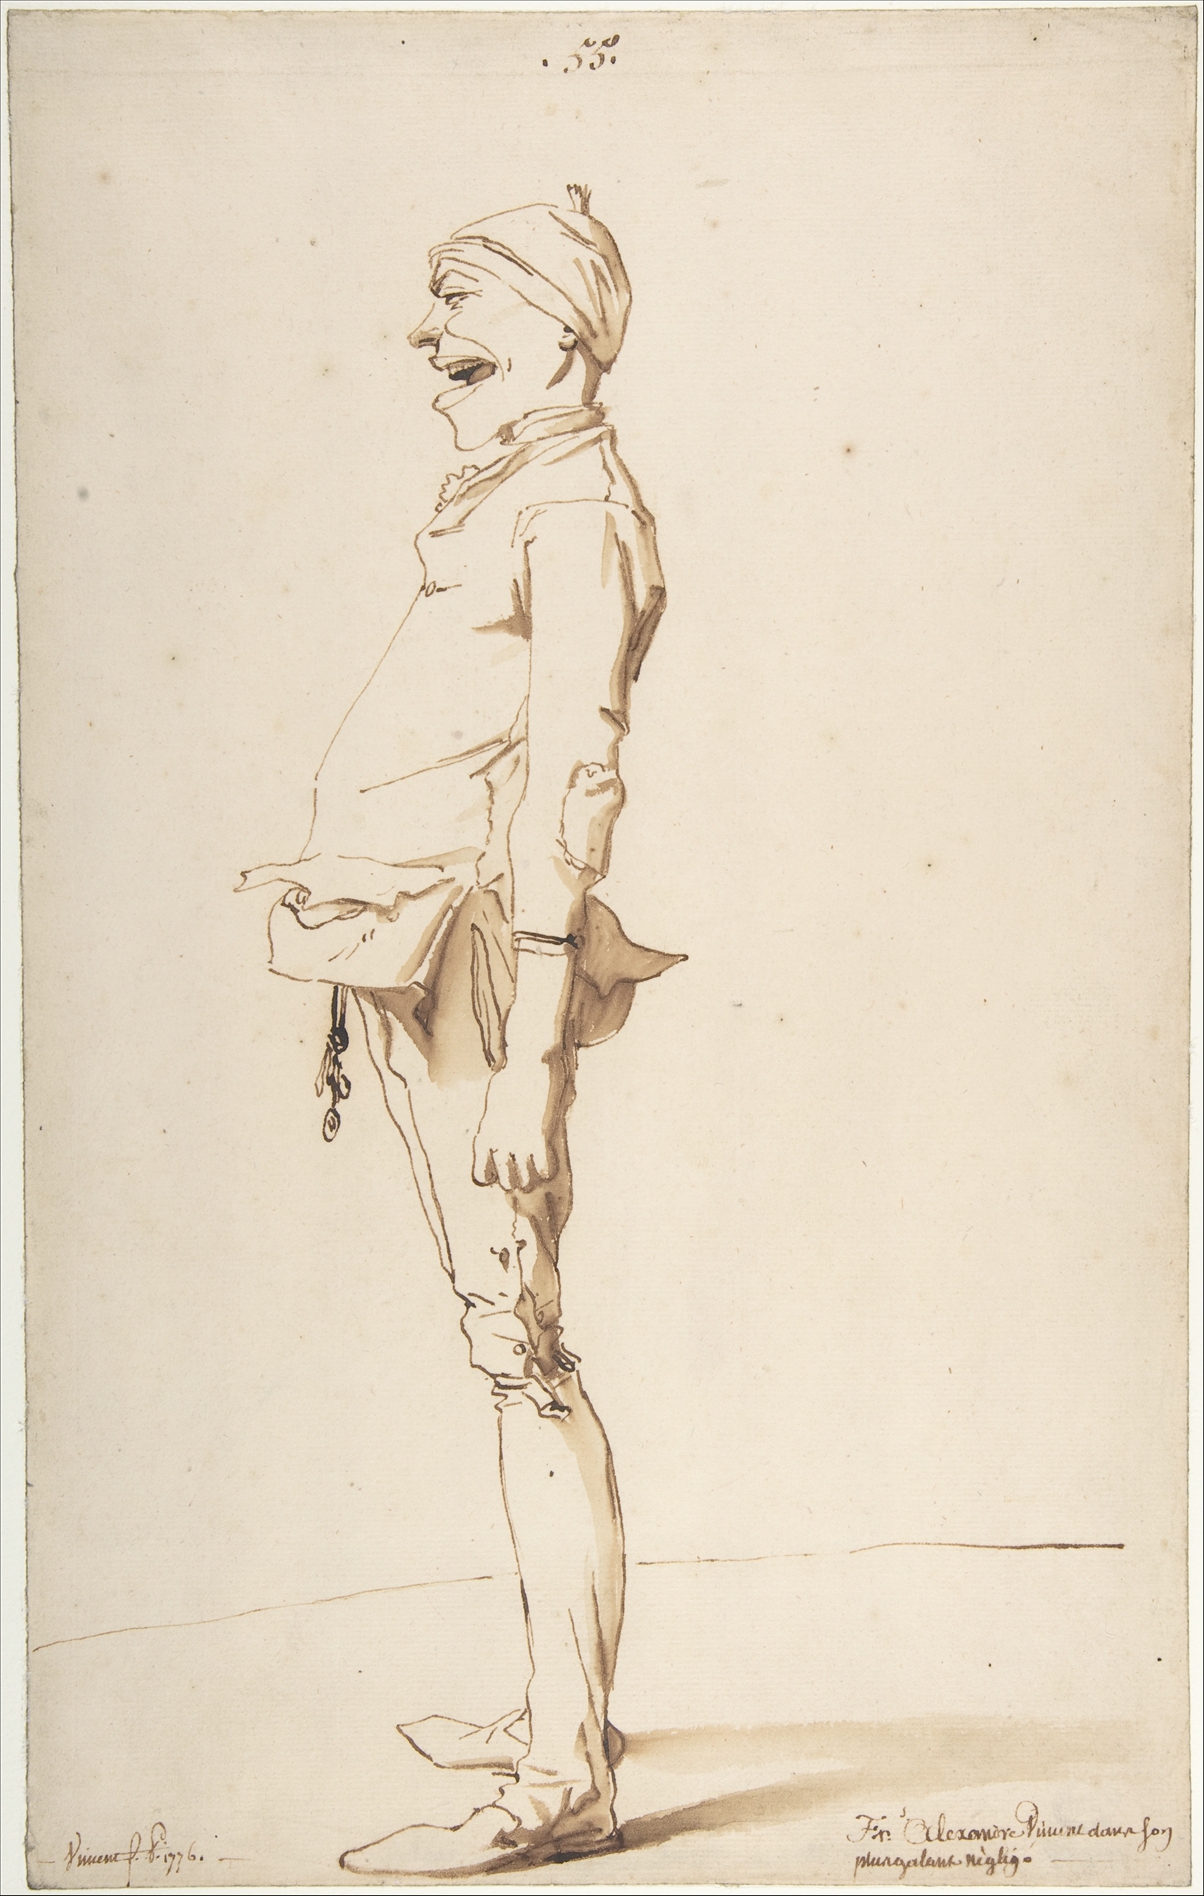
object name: drawing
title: Caricature of the Artist's Younger Brother Marie-Alexandre-François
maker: françois andré vincent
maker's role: artist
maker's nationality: french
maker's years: 1746-1816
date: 1776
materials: ink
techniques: brush, pen, wash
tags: men